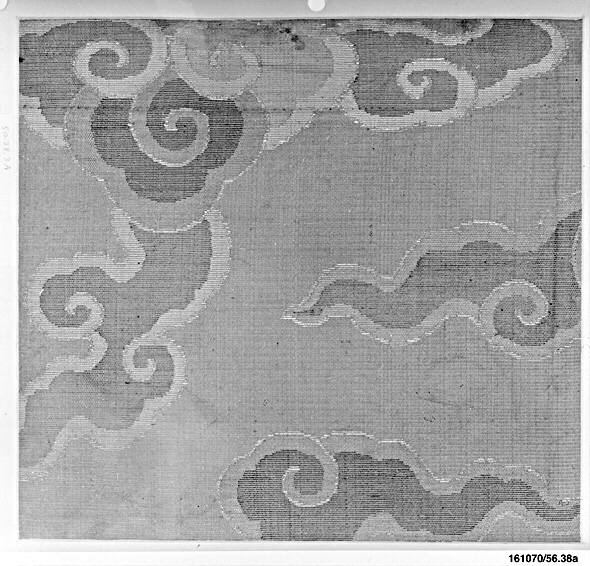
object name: piece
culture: chinese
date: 1501-1700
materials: metal thread, silk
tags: clouds